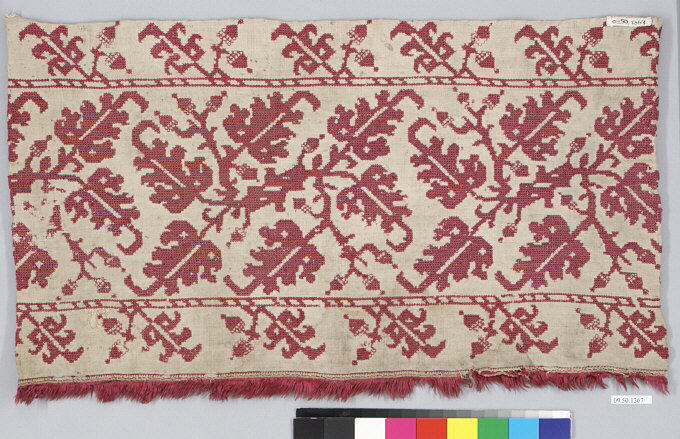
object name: band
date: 1501-1700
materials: linen, silk